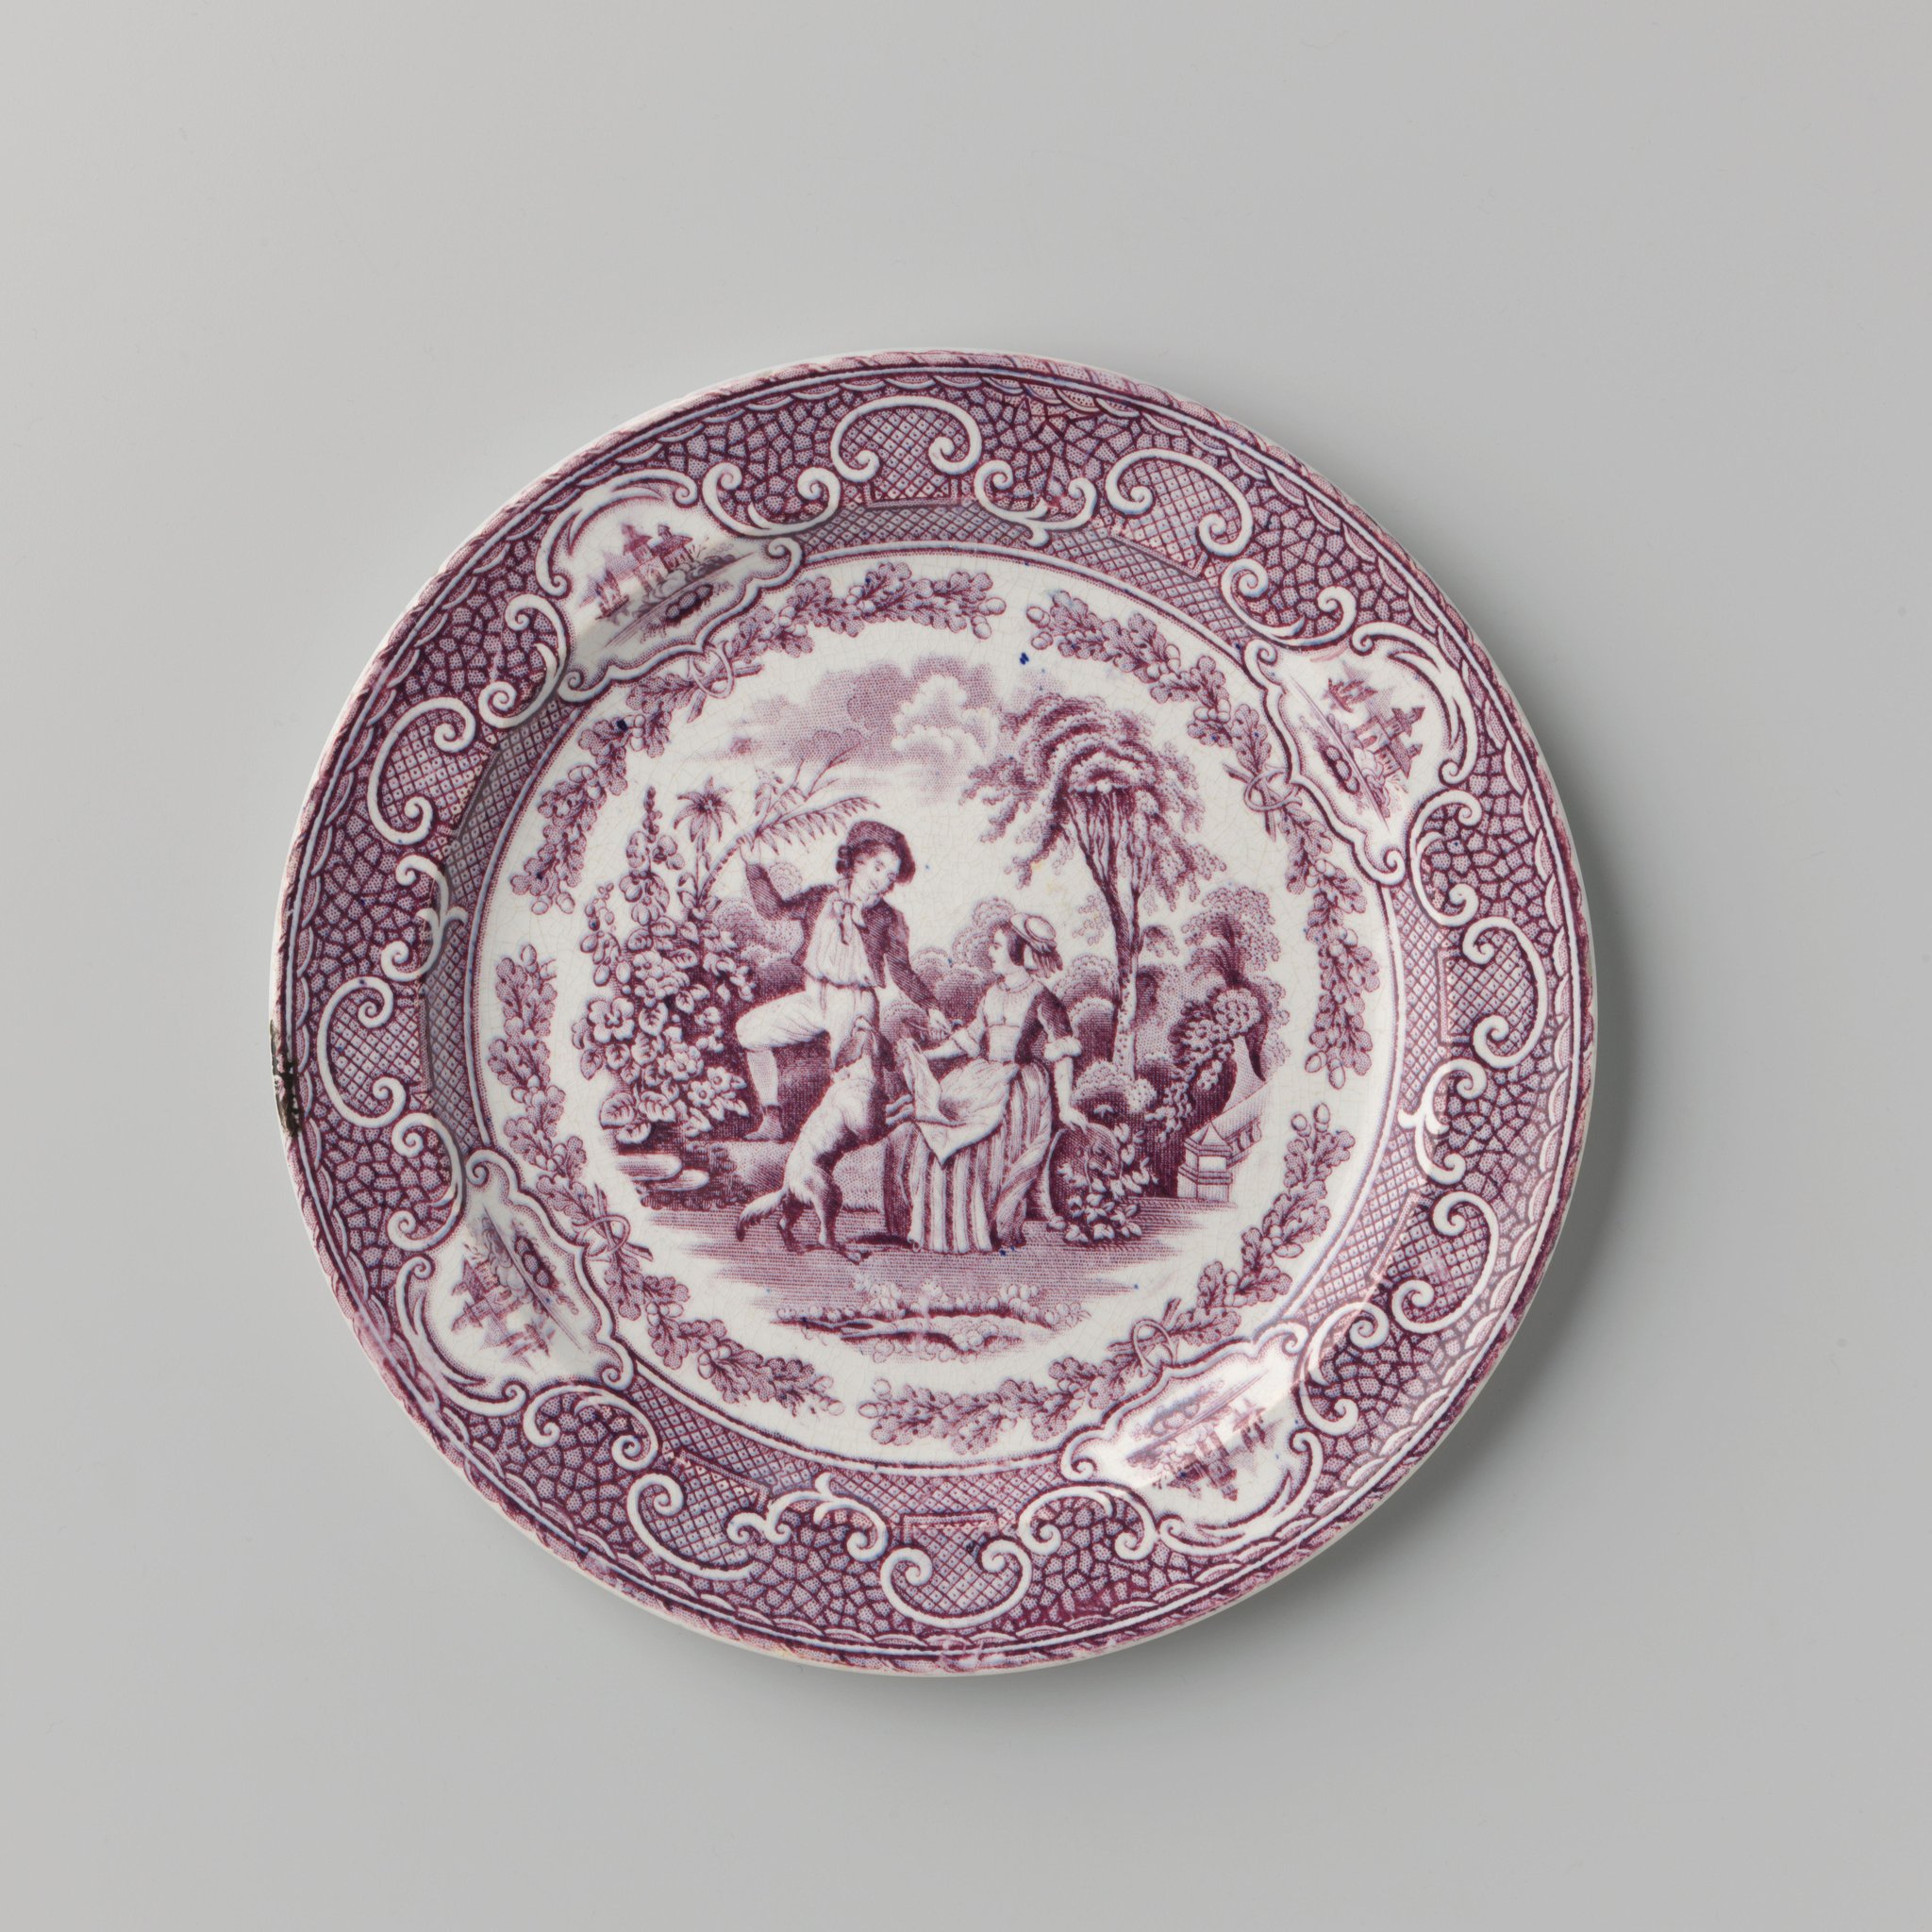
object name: plate dish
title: Bord, met op het plat een herder en een herderin in een tuin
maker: nicolaas antoine bosch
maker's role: ceramicist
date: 1853-1867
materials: creamware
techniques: transfer decoration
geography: maastricht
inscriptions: mark: ‘HERDERS // N. A. BOSCH’, check stamp: ‘N. A. BOSCH // 7 // MAASTRICHT’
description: Bord van aardewerk met lila transferdecor. Op het plat een herder en een herderin met hond in een tuin. Rond de voorstelling een band van eikentakken. De rand met vier cartouches met gebouwen. Tussen de cartouches c-voluten en geometrische motieven.